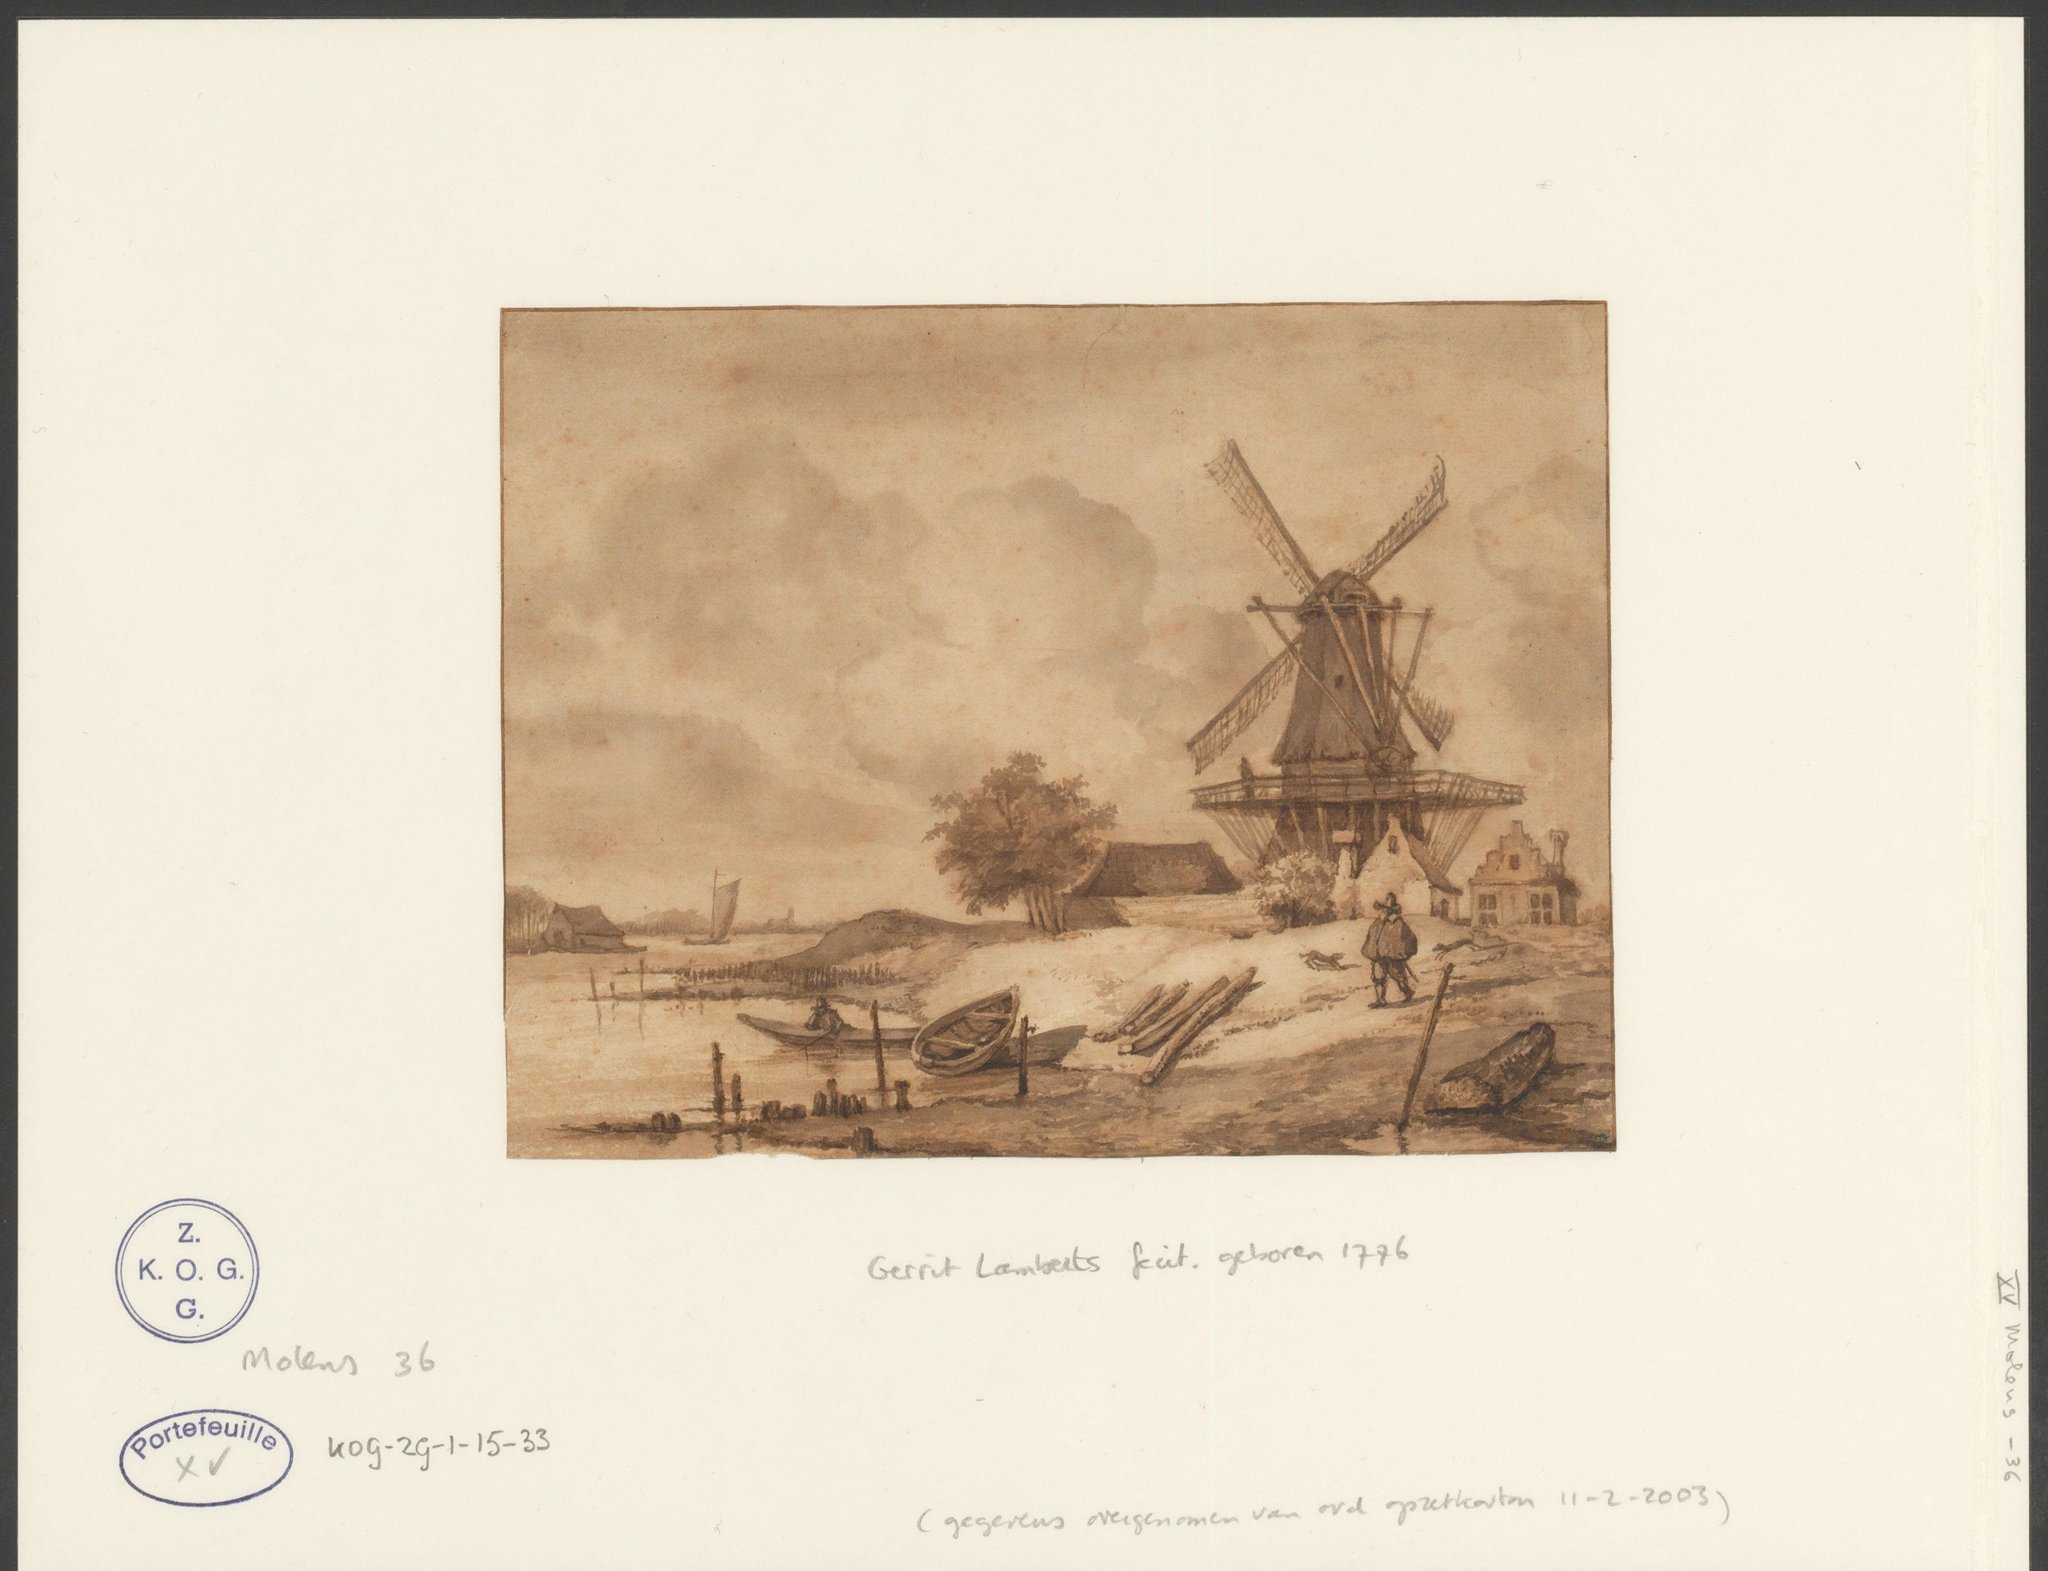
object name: drawing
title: Molen langs een rivier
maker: gerrit lamberts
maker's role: bookseller, draughtsman, print maker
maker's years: 1776-1850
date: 1810-1850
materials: ink, paper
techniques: brush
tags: river, river bank, windmill in landscape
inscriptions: stamp, collector's mark: Lugt 1641, inscription: ‘Gerrit Lamberts geb 1776’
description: Onderwerpsrubrieken binnen de Atlas Zeden en Gewoonten: Handel, nijverheid en verkeer, Molens.